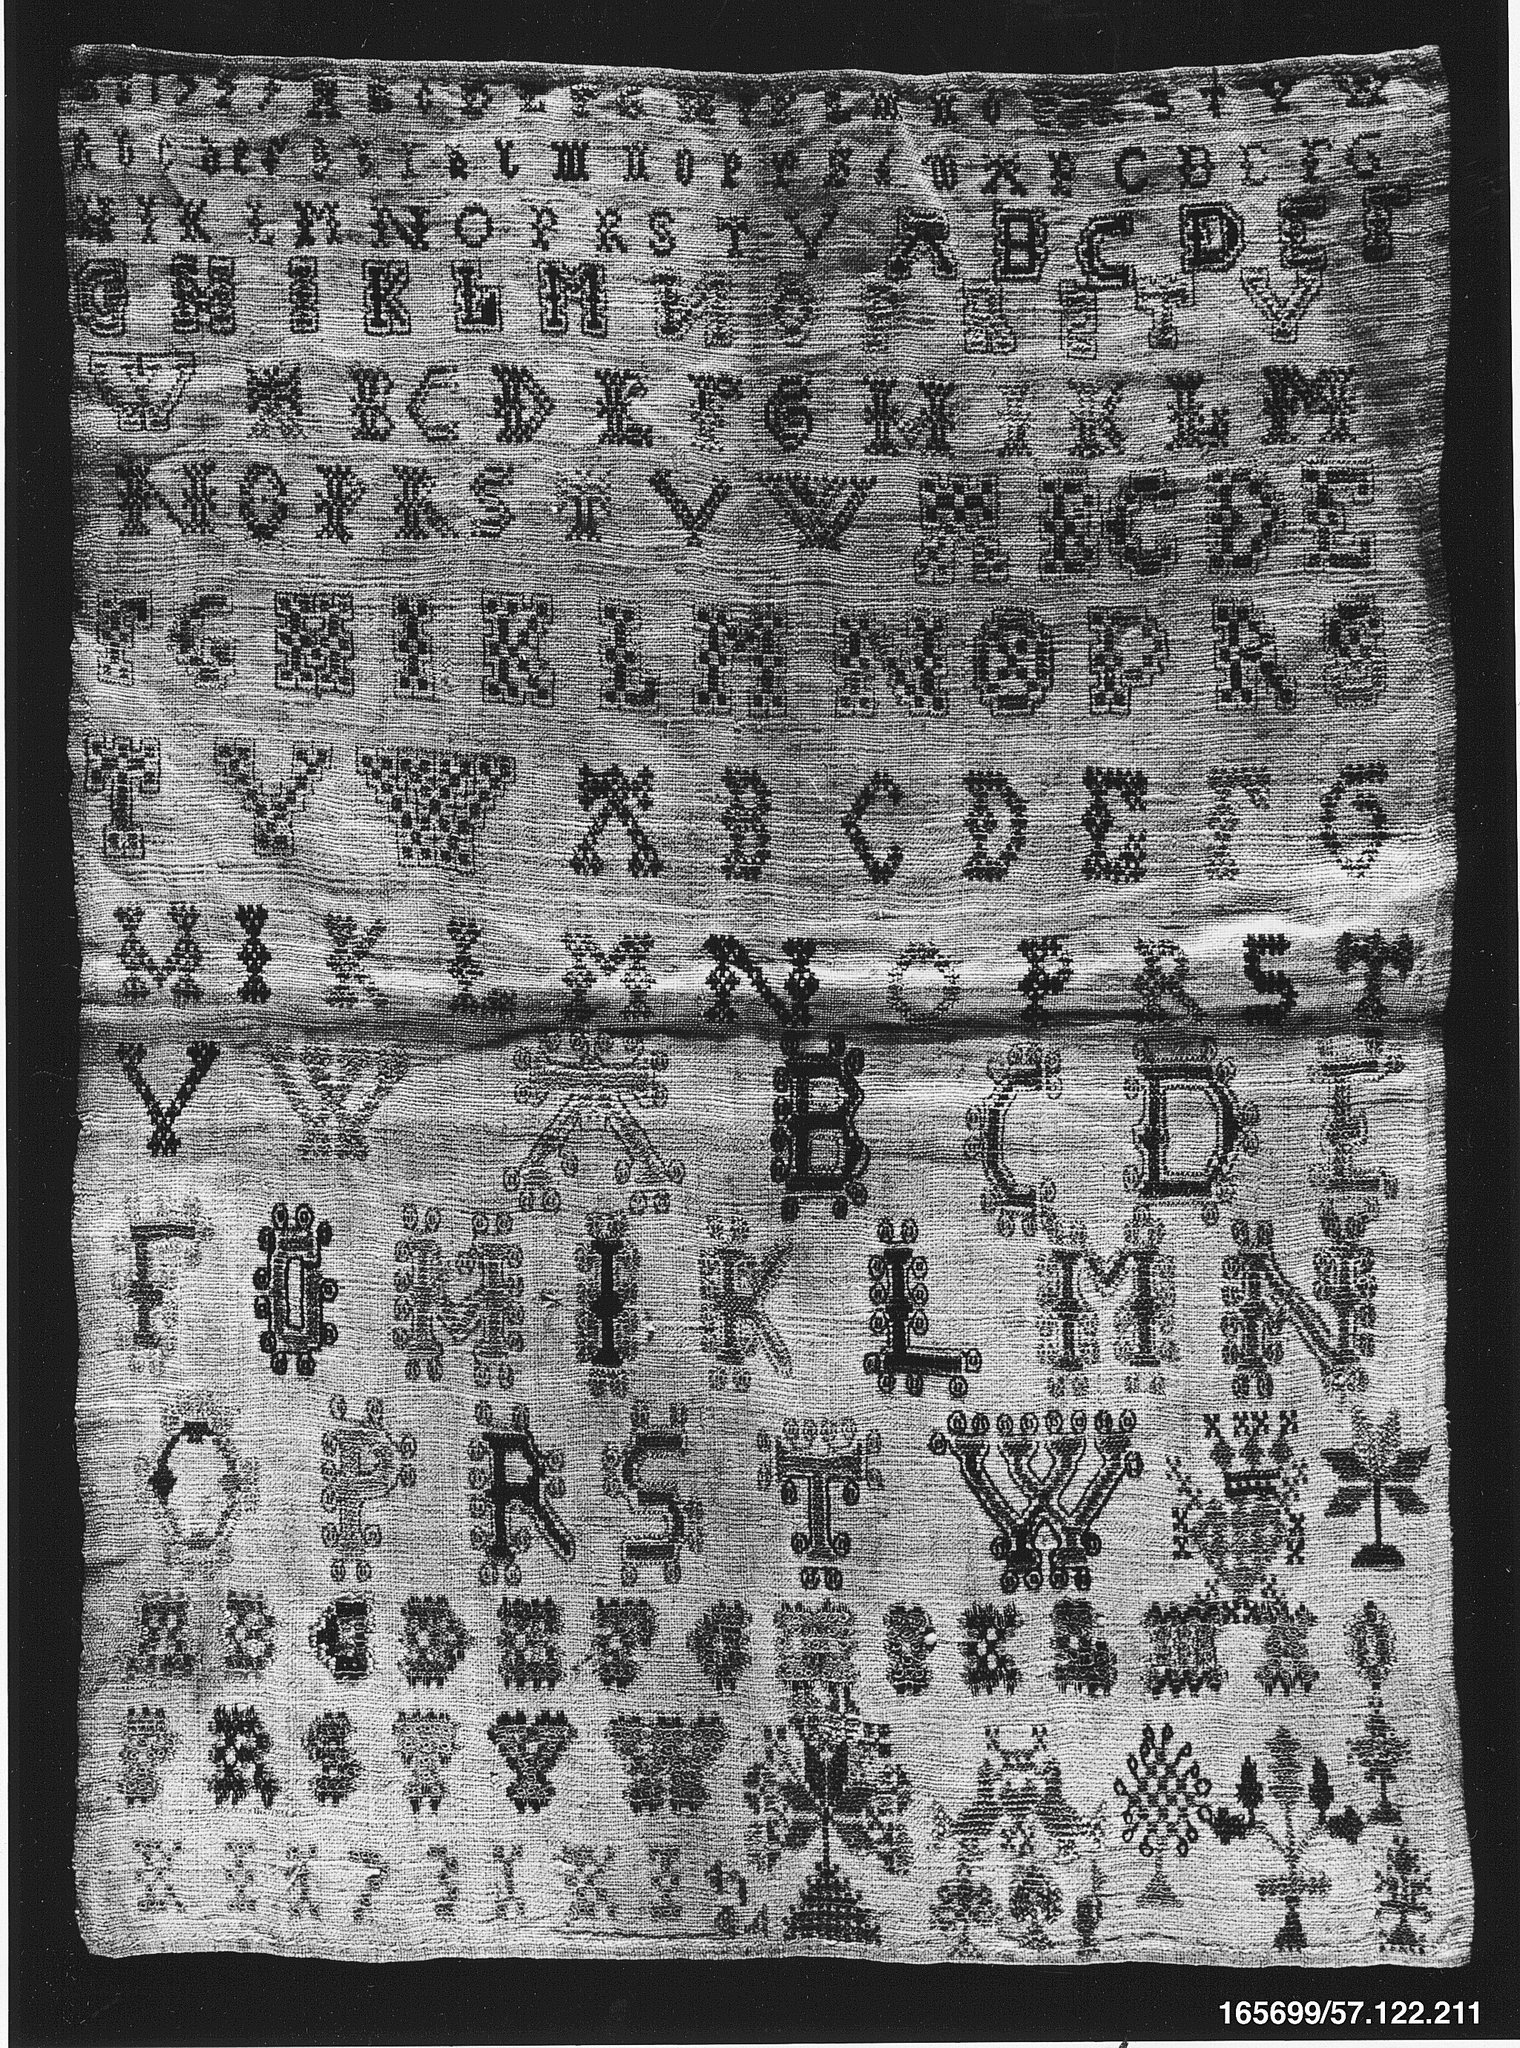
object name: sampler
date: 1729-1731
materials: linen, silk